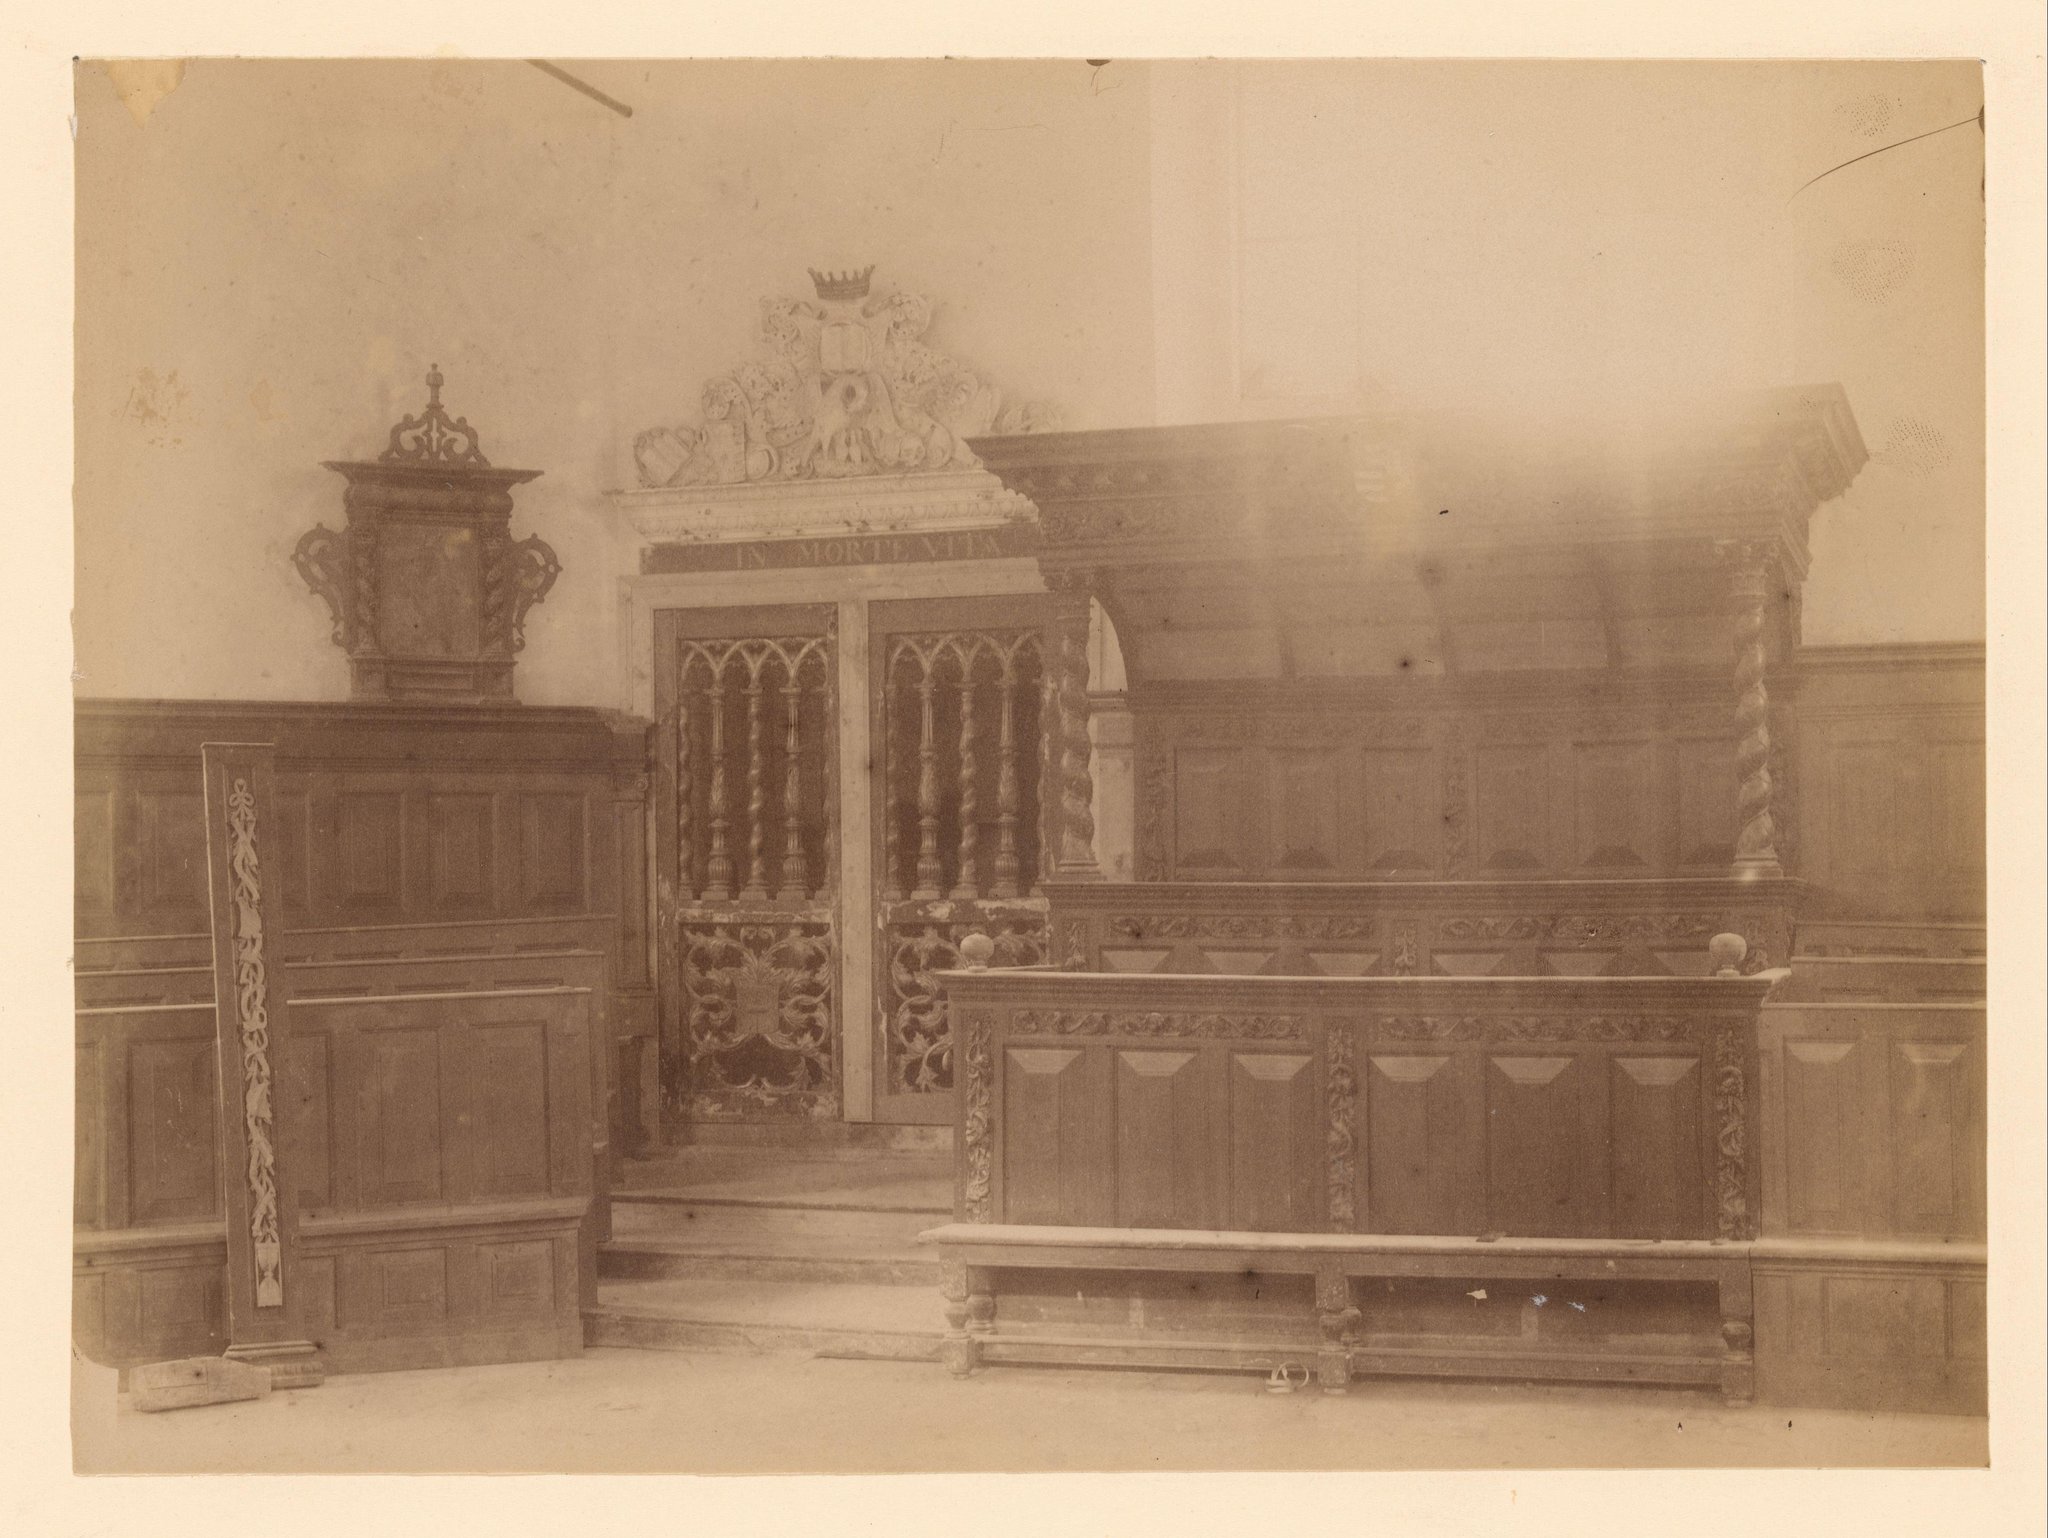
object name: photograph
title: Van Harens-bank in de Van Harenskerk te Sint-Annaparochie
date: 1898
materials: cardboard, photographic support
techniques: albumen print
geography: van harenskerk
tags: bench, interior of church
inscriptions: annotation: ‘N.H. Kerk te St Anne parochie / gezicht op de van Harensbank / en op de ingang naar de van / Harenskapel’, annotation: ‘St. Annaparochie/ gem. Het Bilt’